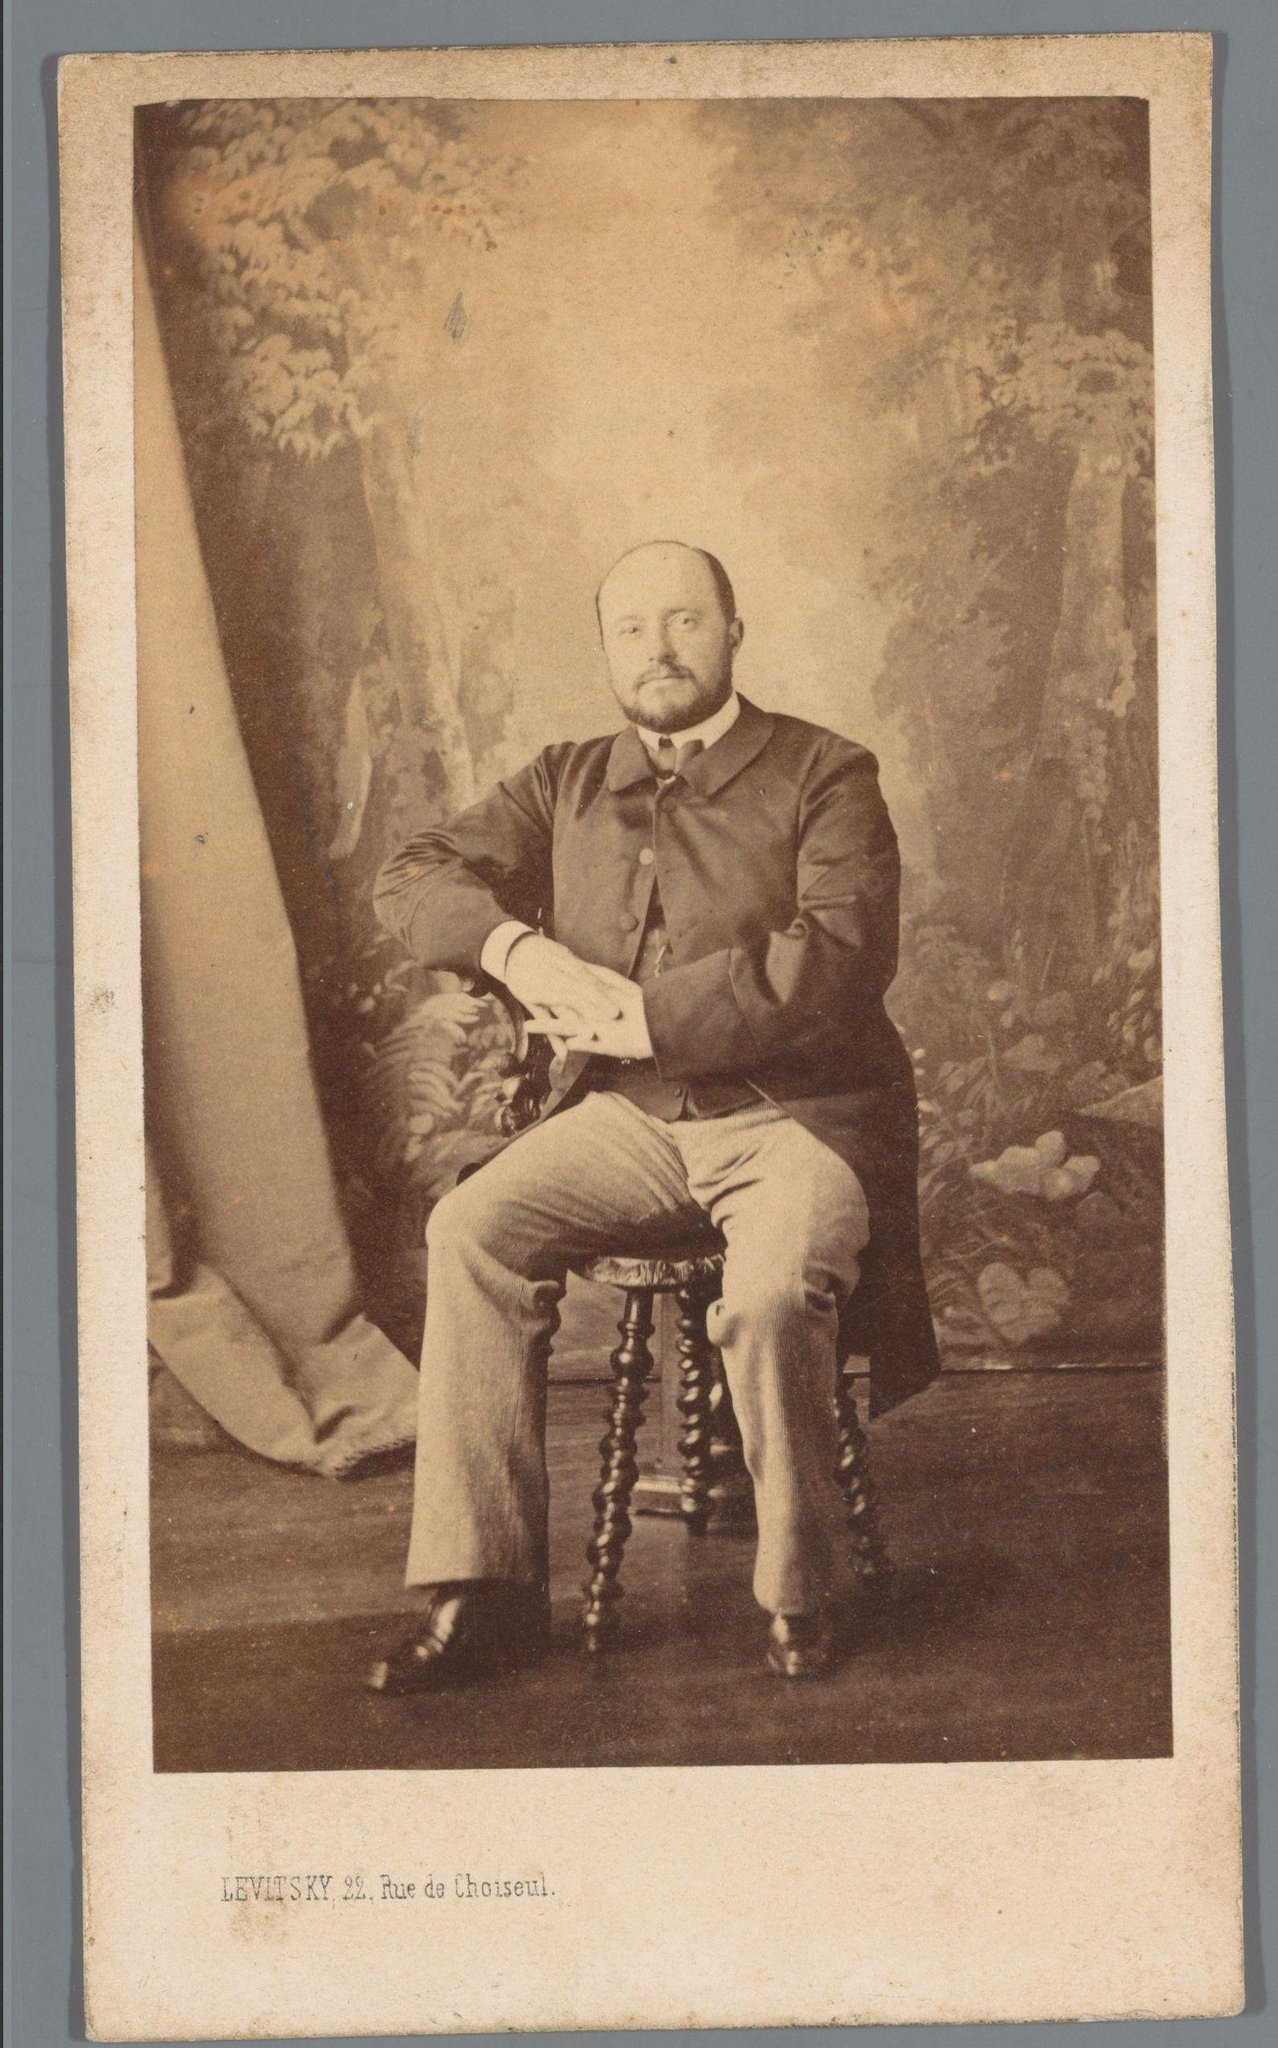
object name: photograph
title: Portret van een onbekende man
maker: sergei lvovich levitsky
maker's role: fotograaf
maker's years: 1819-1898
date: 1858-1865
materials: cardboard, paper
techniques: albumen print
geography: paris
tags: adult man, anonymous historical person portrayed, paris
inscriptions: inscription: ‘Levitsky, 22, Rue de Choiseul.’